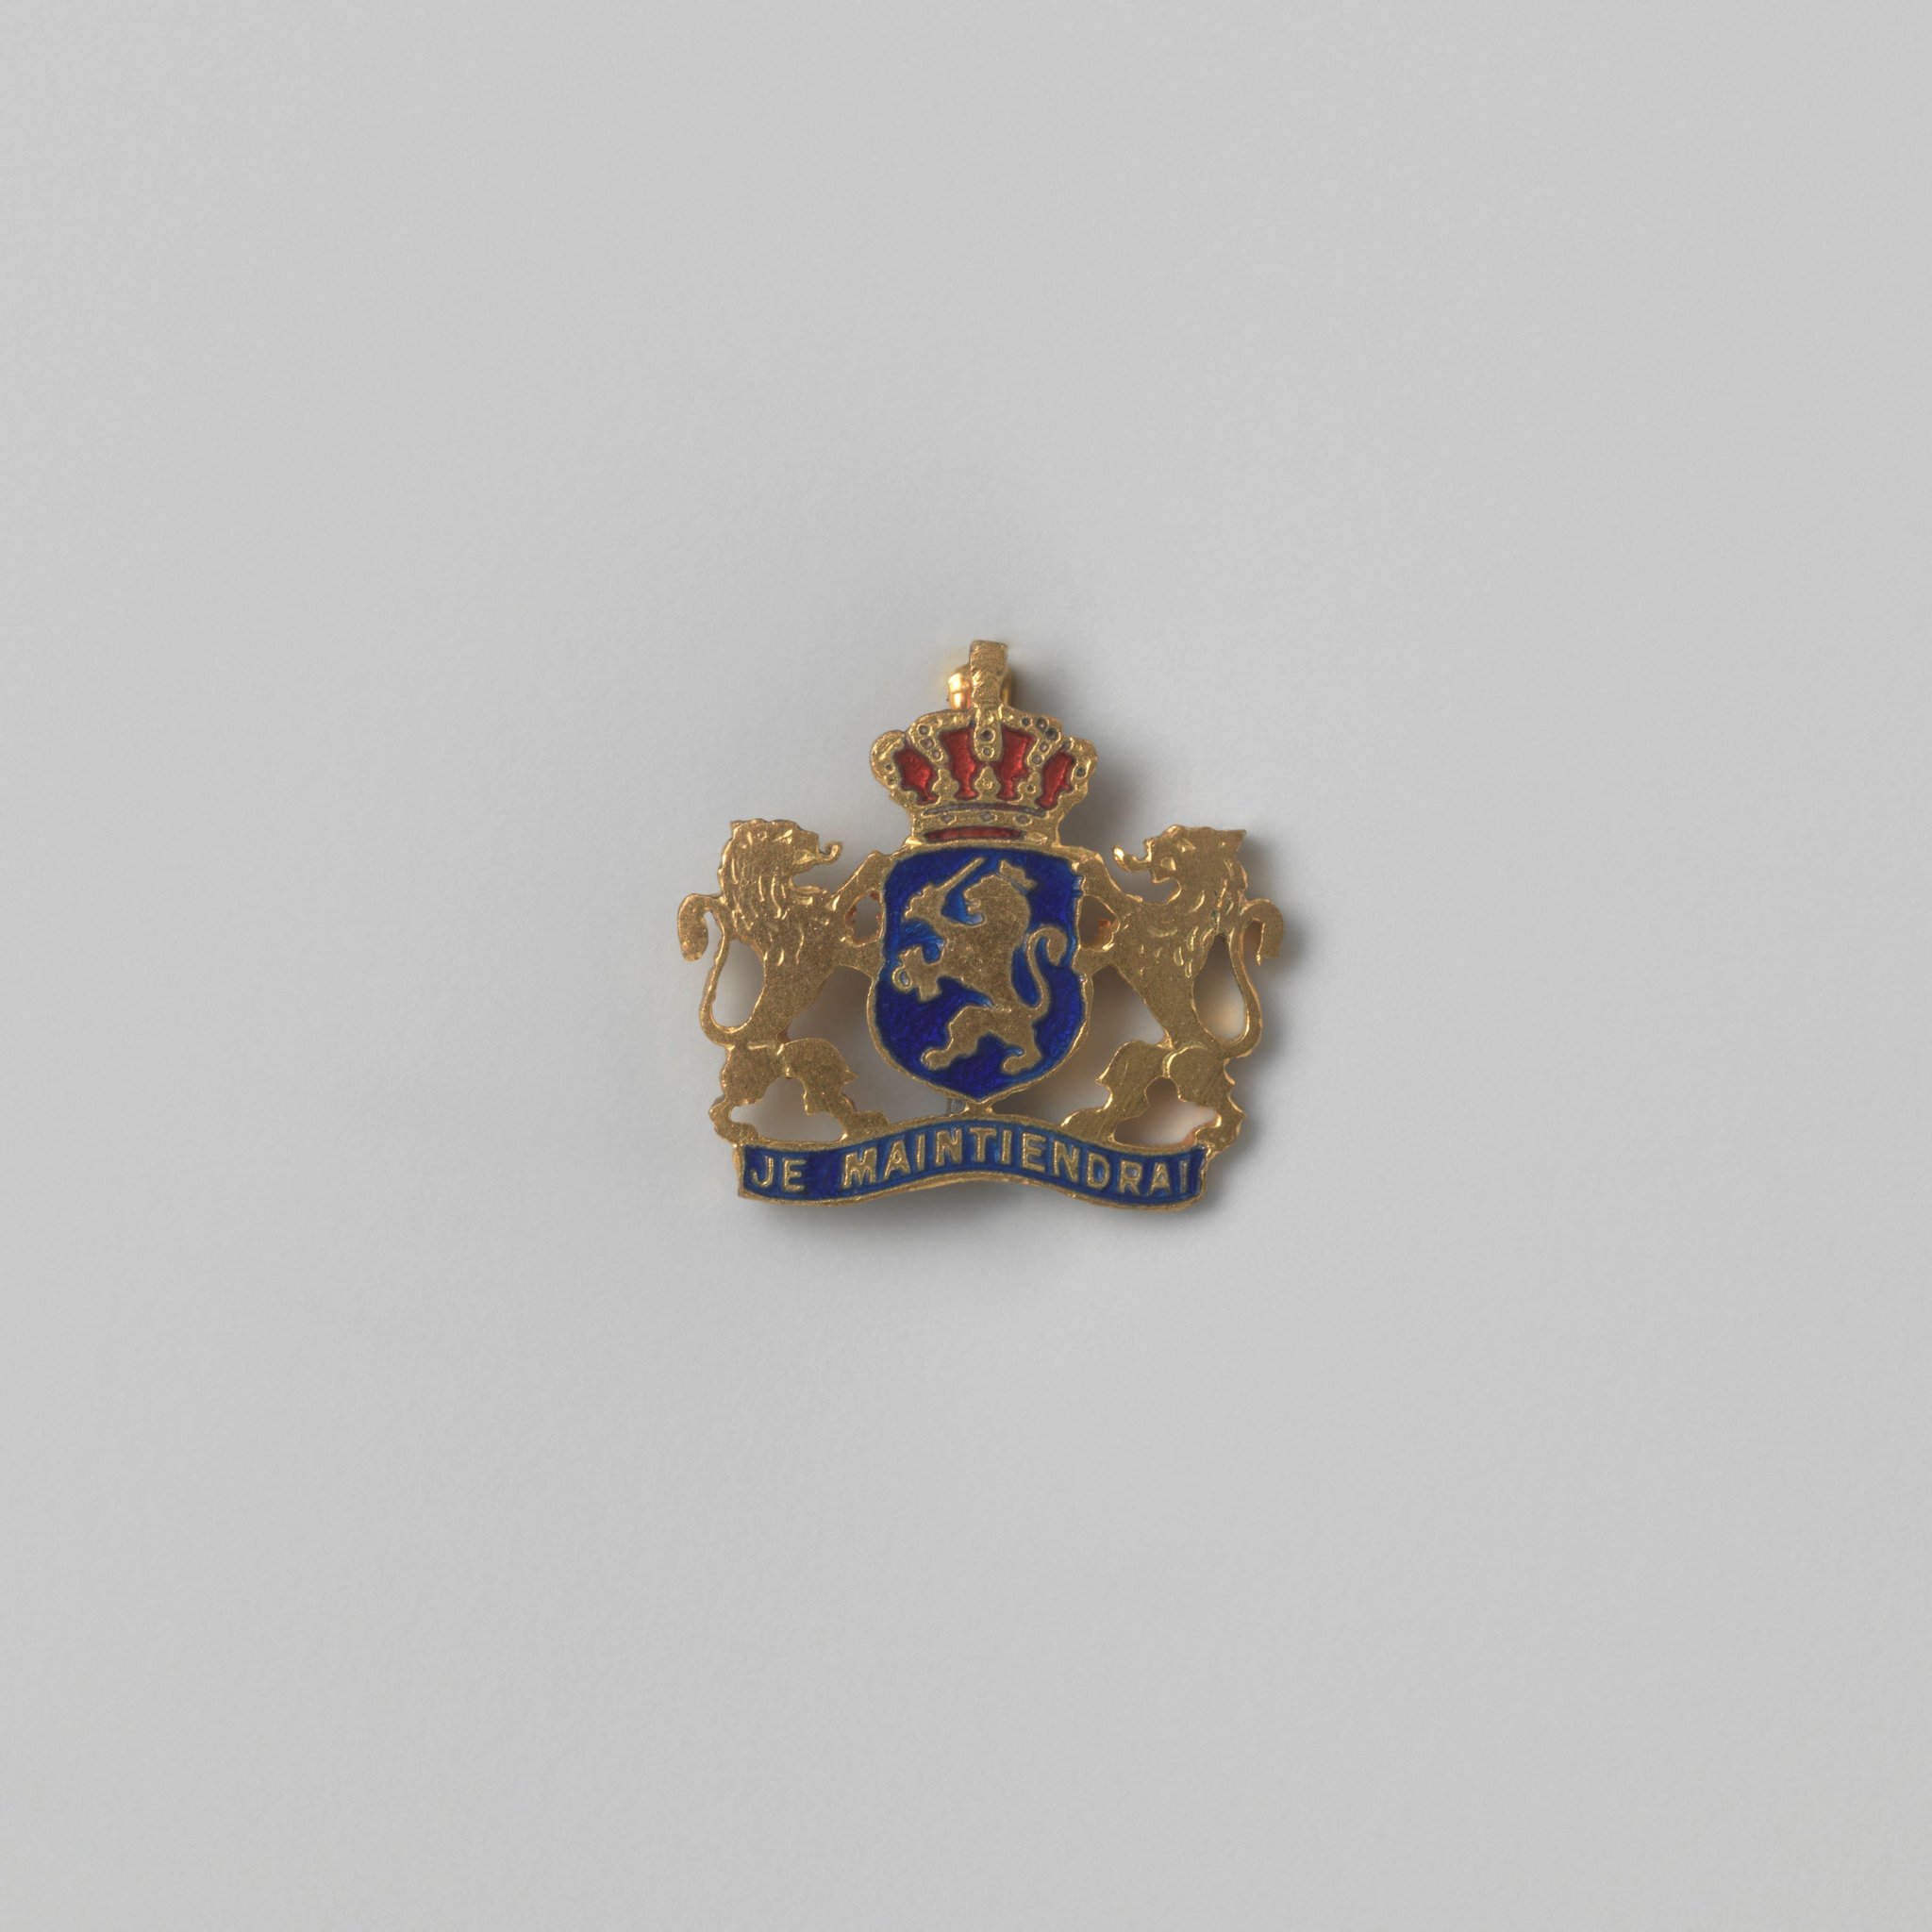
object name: brooch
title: Broche van geëmailleerd metaal van het Nederlandse wapen in ajour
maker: Anonymous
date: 1940-1945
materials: metal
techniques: embroidery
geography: netherlands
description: Broche van geëmailleerd metaal van het Nederlandse wapen in ajour met 'JE MAINTIENDRAI' voorzien van een haaksluiting. Uit een ensemble van elf stuks van mejuffrouw Henriquez de Castro.